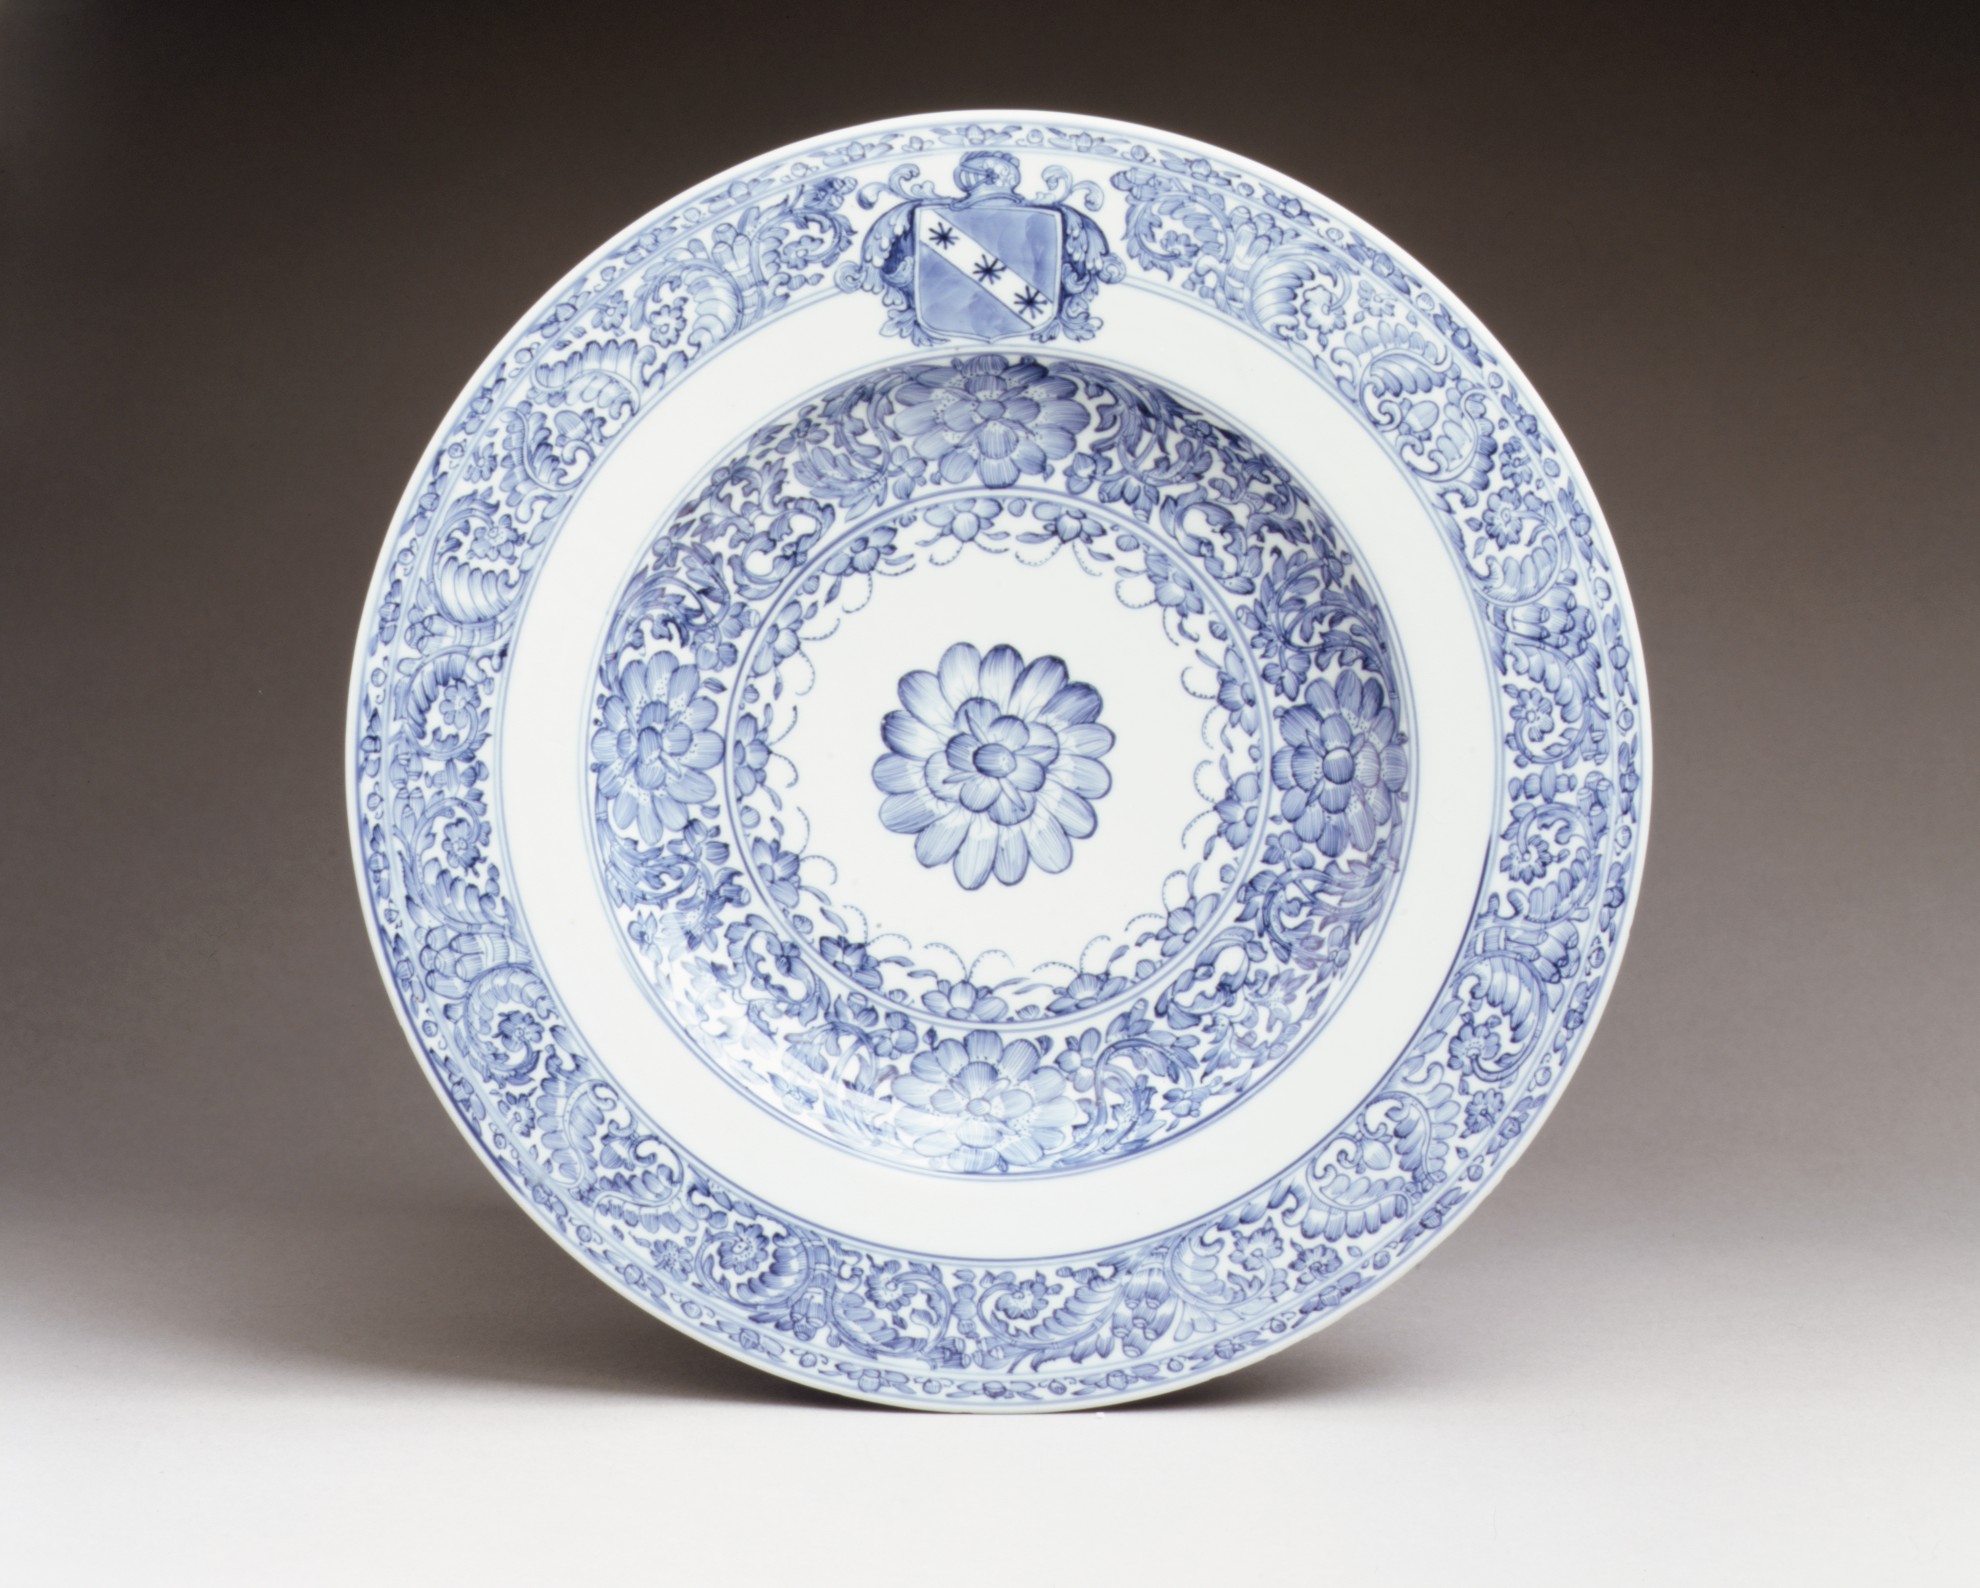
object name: dish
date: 1667-1733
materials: hard paste porcelain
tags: flowers,insignia